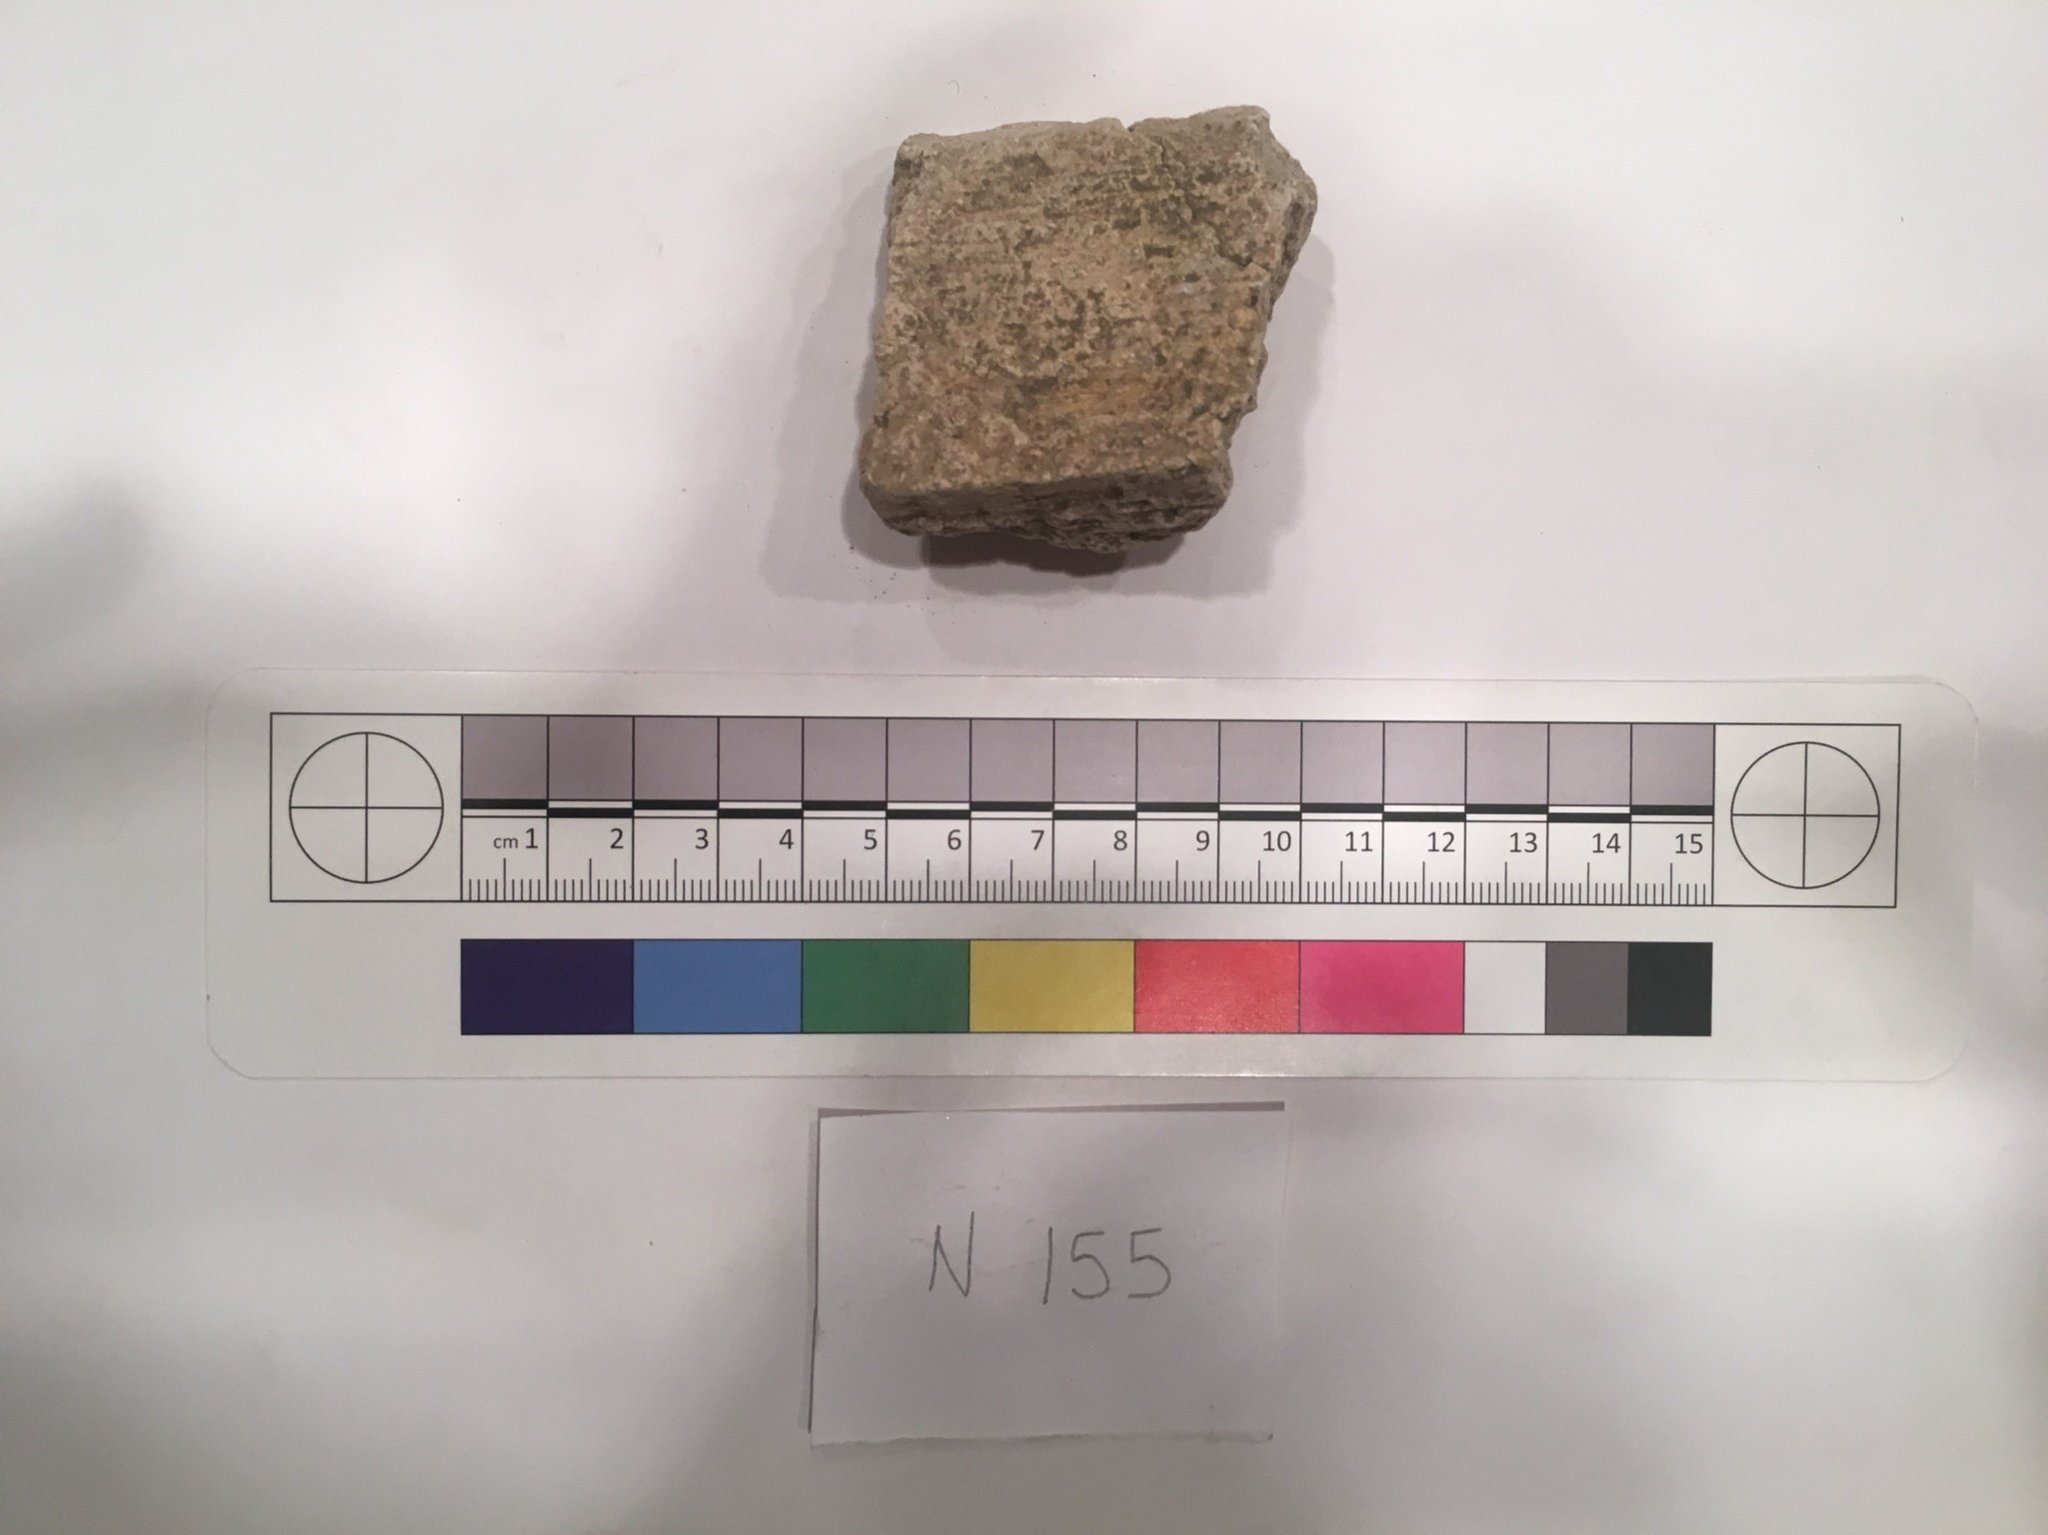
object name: fragment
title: Stucco Fragment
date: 701-1200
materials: plaster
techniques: carving, painting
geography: iran